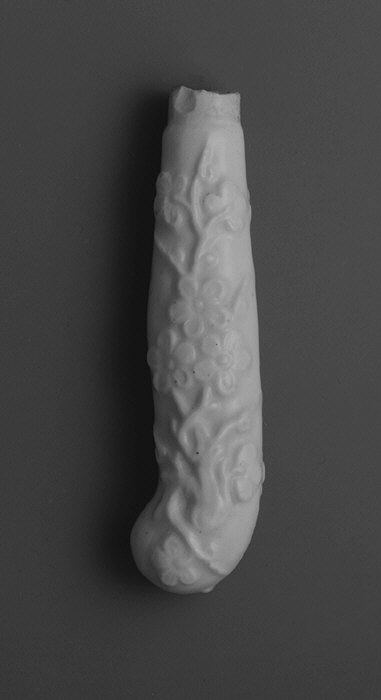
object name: knife handle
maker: chelsea porcelain manufactory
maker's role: factory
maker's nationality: british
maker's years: 1744-1784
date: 1755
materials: soft paste porcelain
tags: hilts,flowers